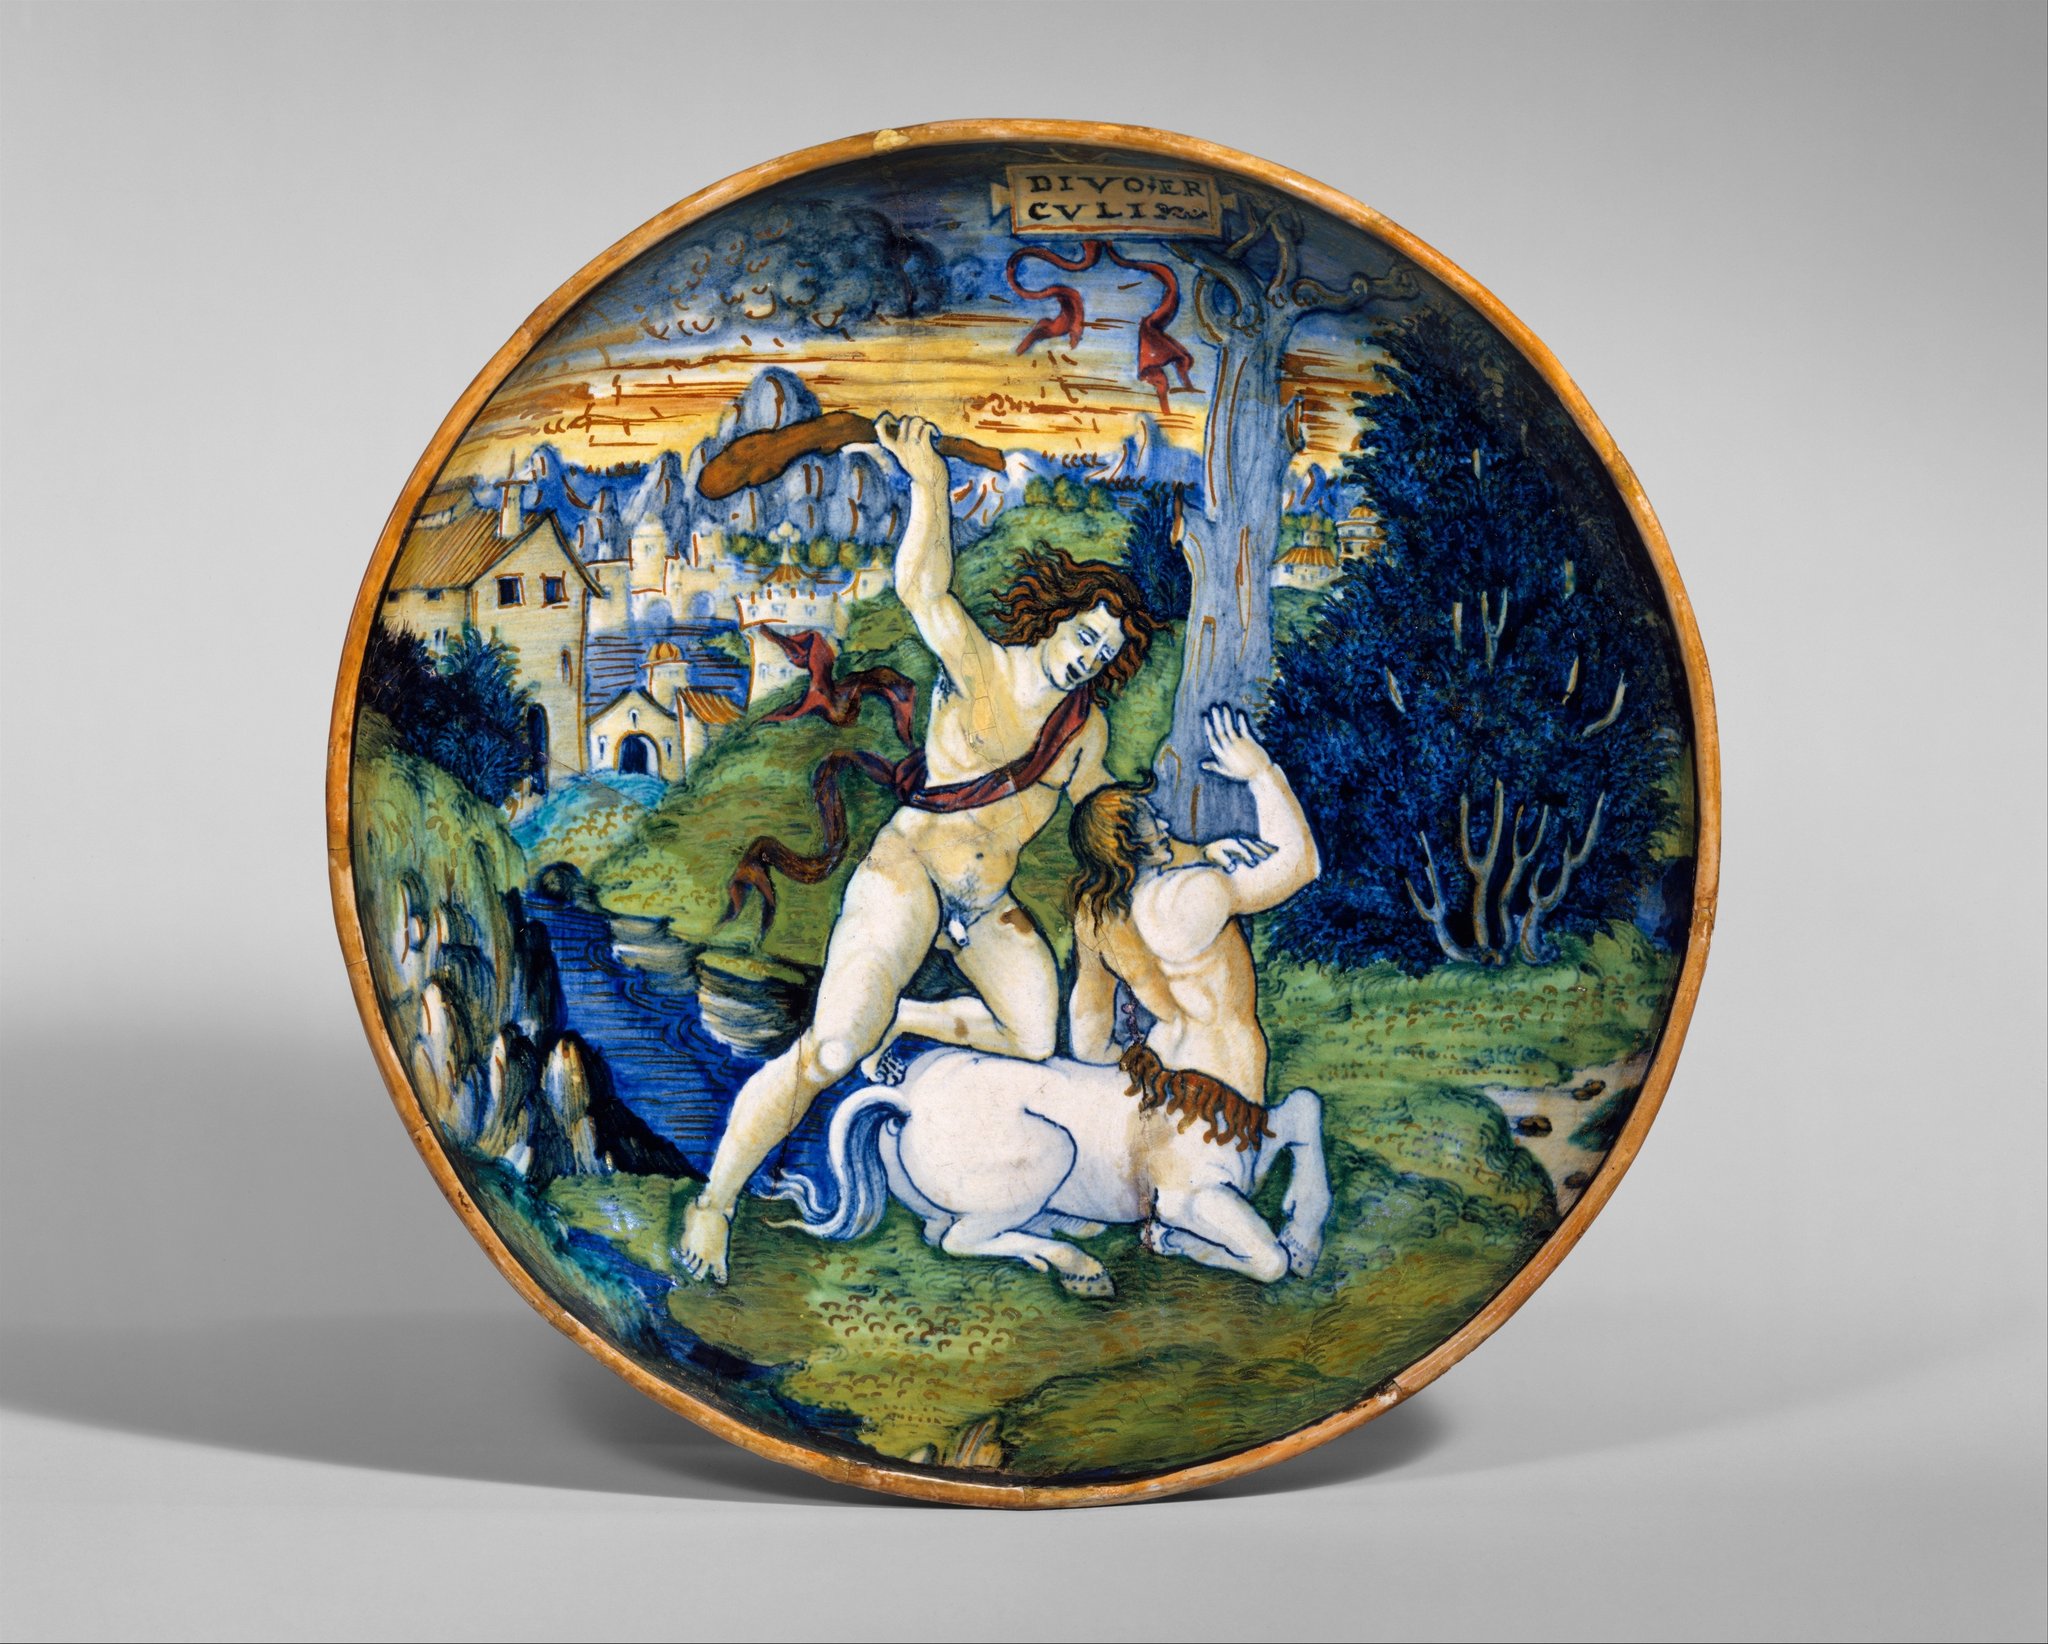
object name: dish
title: Dish (coppa): Hercules slays the centaur Nessus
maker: maestro giorgio andreoli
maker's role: artist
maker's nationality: italian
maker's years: 1500-1550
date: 1525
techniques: maiolica, glazing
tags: hercules,centaurs